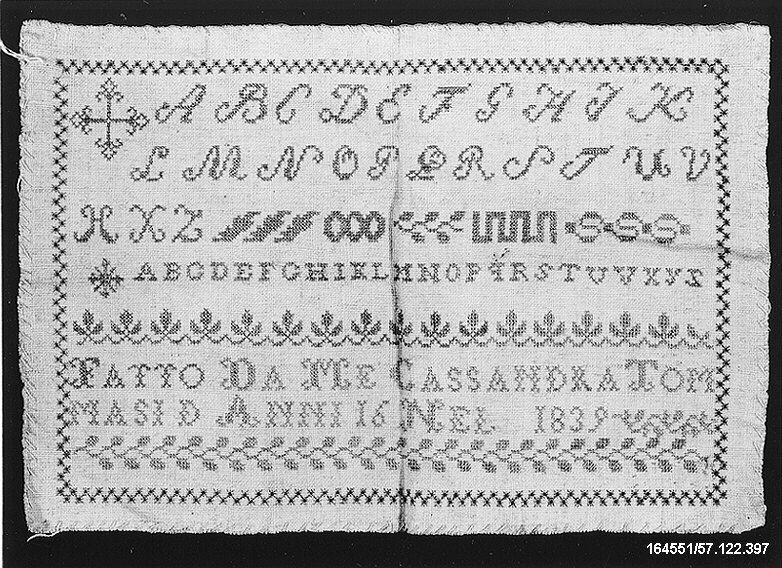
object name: sampler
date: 1839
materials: linen, silk